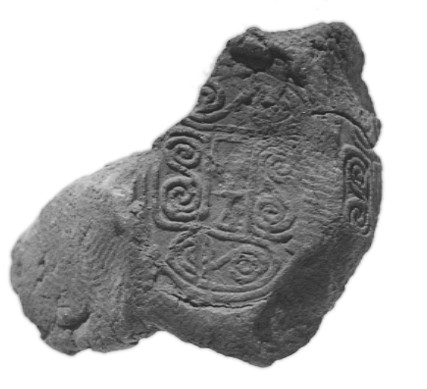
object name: sealing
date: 2030-1640 BCE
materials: clay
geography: egypt